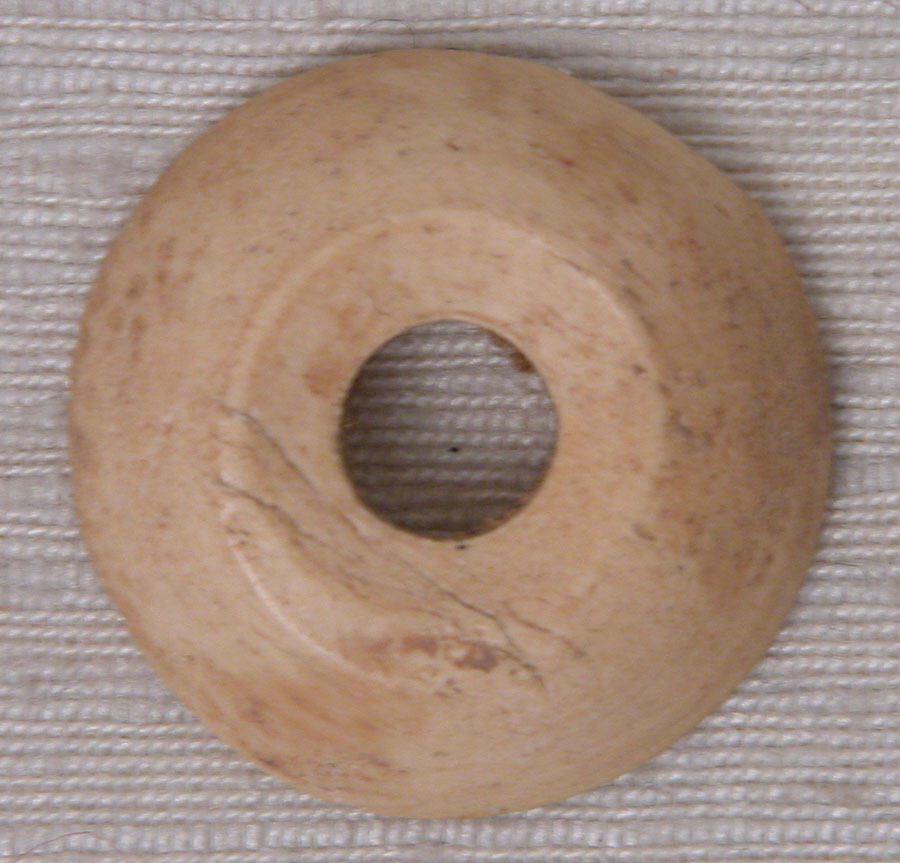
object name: button or bead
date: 801-1000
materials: bone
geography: iran